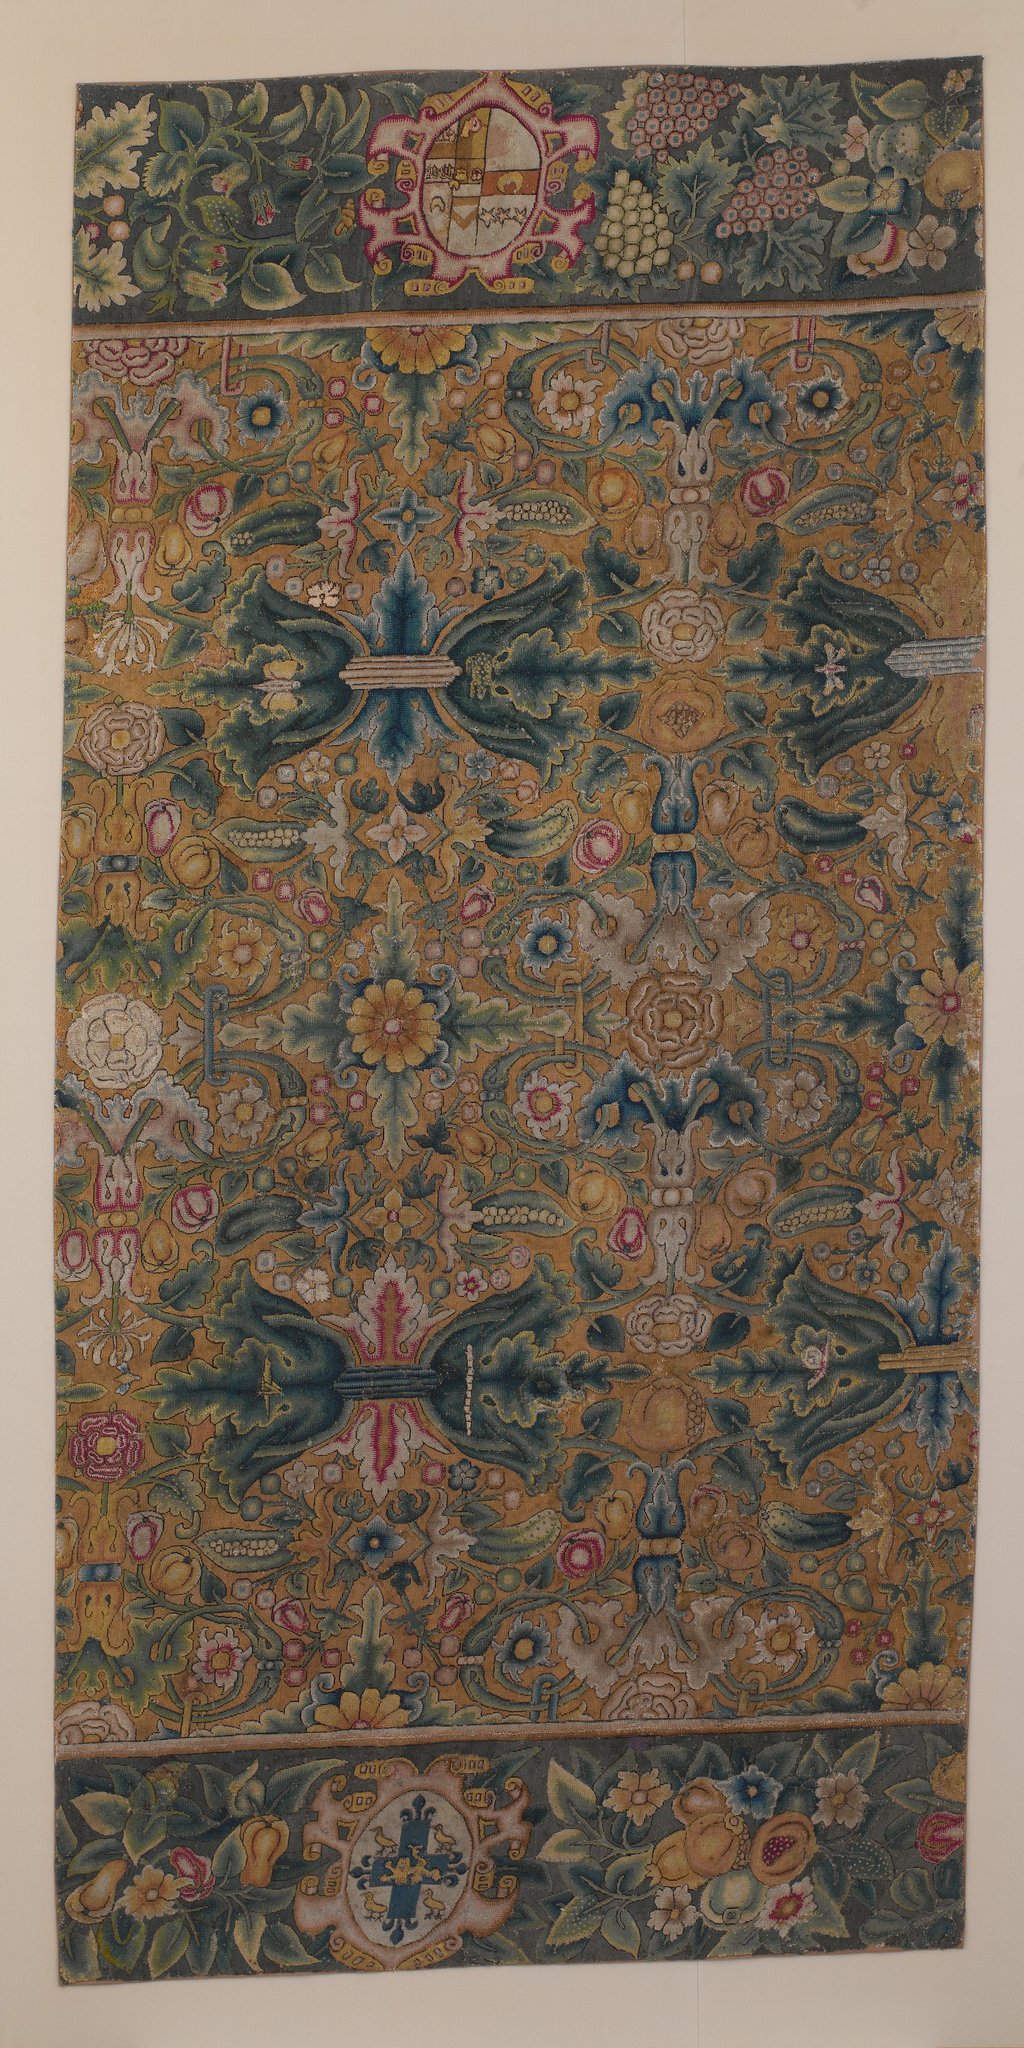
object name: table carpet fragment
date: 1567-1600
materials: canvas, thread, wool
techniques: stitching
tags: flowers